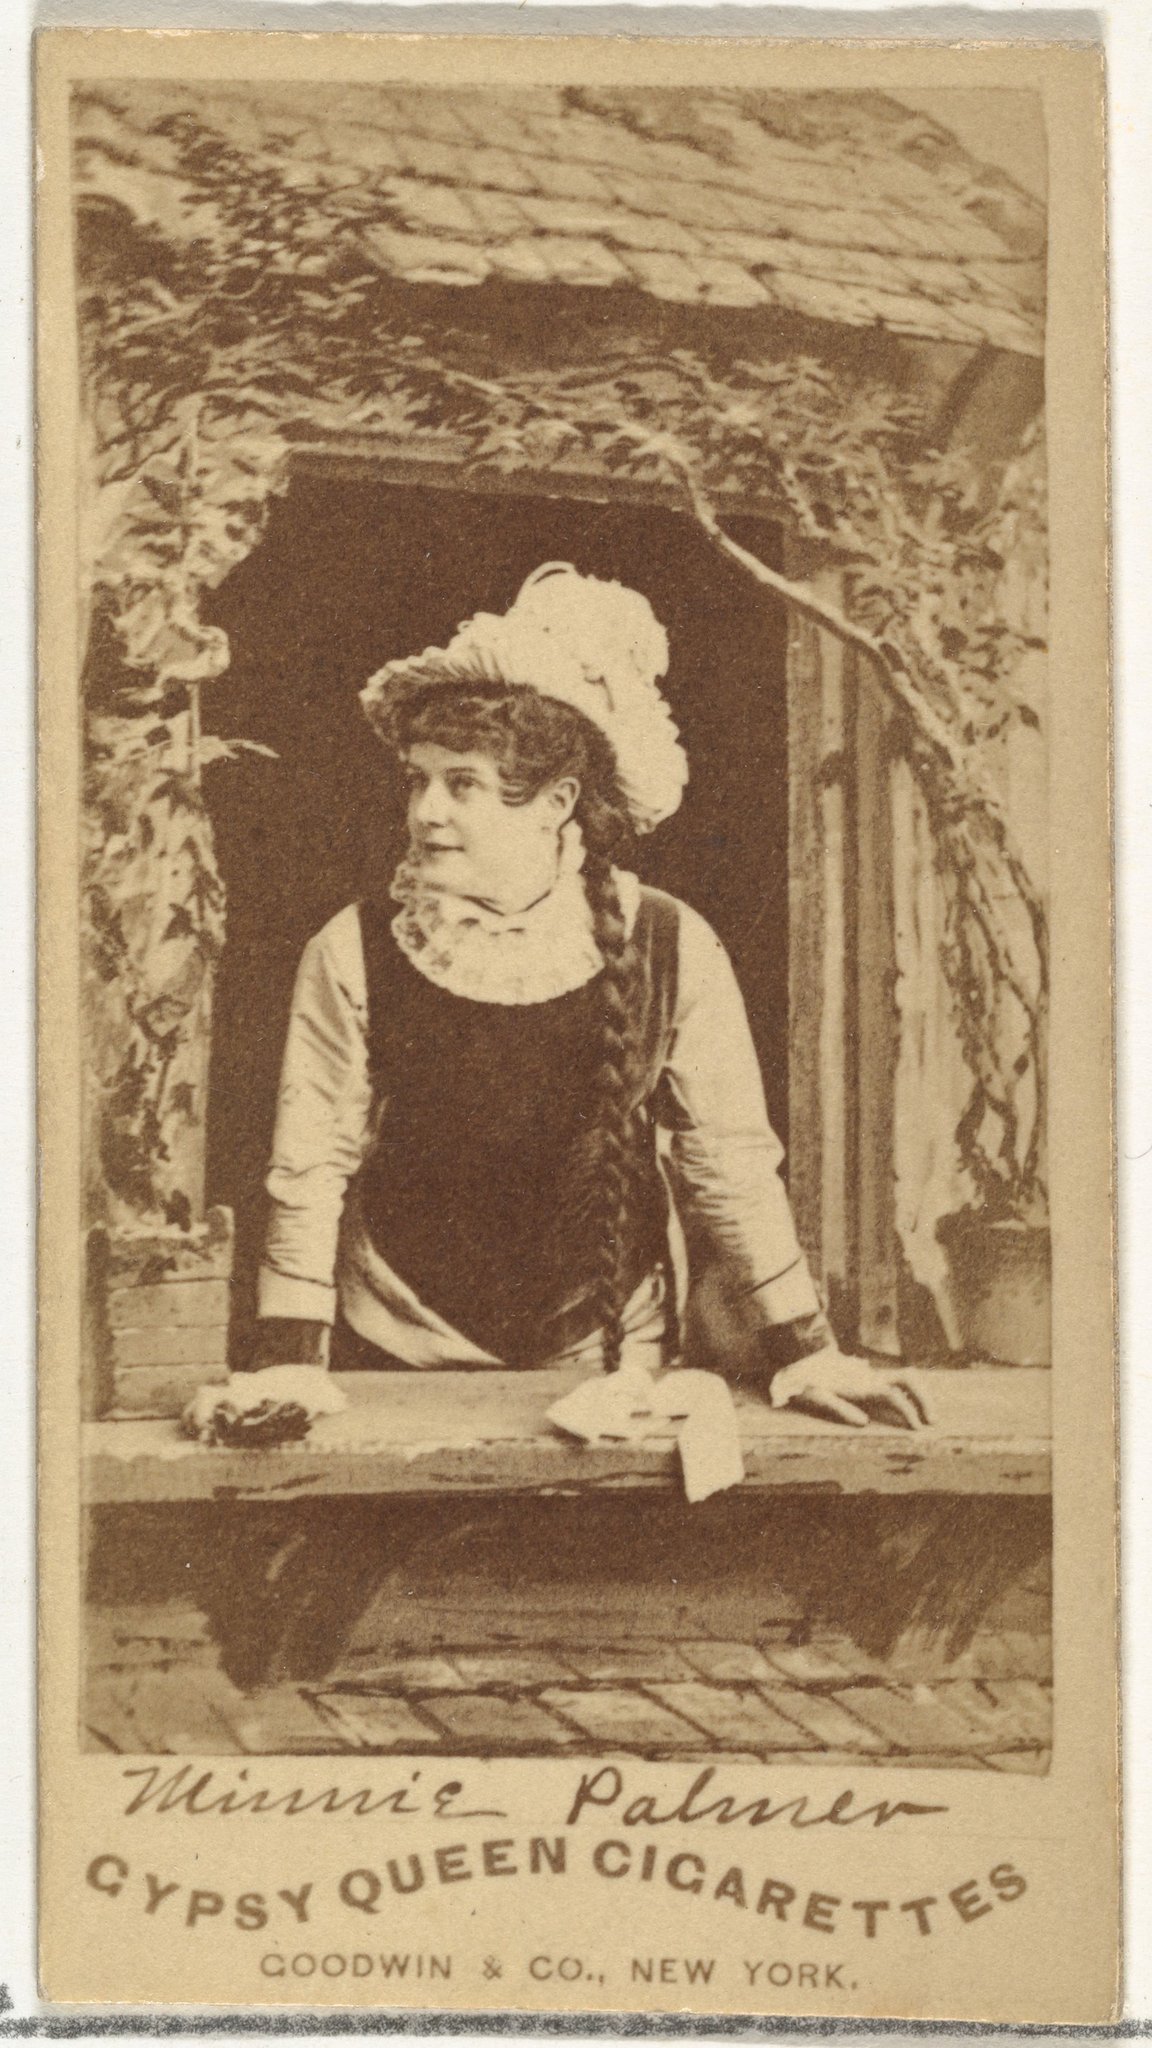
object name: photograph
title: Minnie Palmer, from the Actors and Actresses series (N171) for Gypsy Queen Cigarettes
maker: goodwin & company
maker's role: publisher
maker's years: 1850-1950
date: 1886-1890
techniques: albumen silver print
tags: portraits,women,actresses